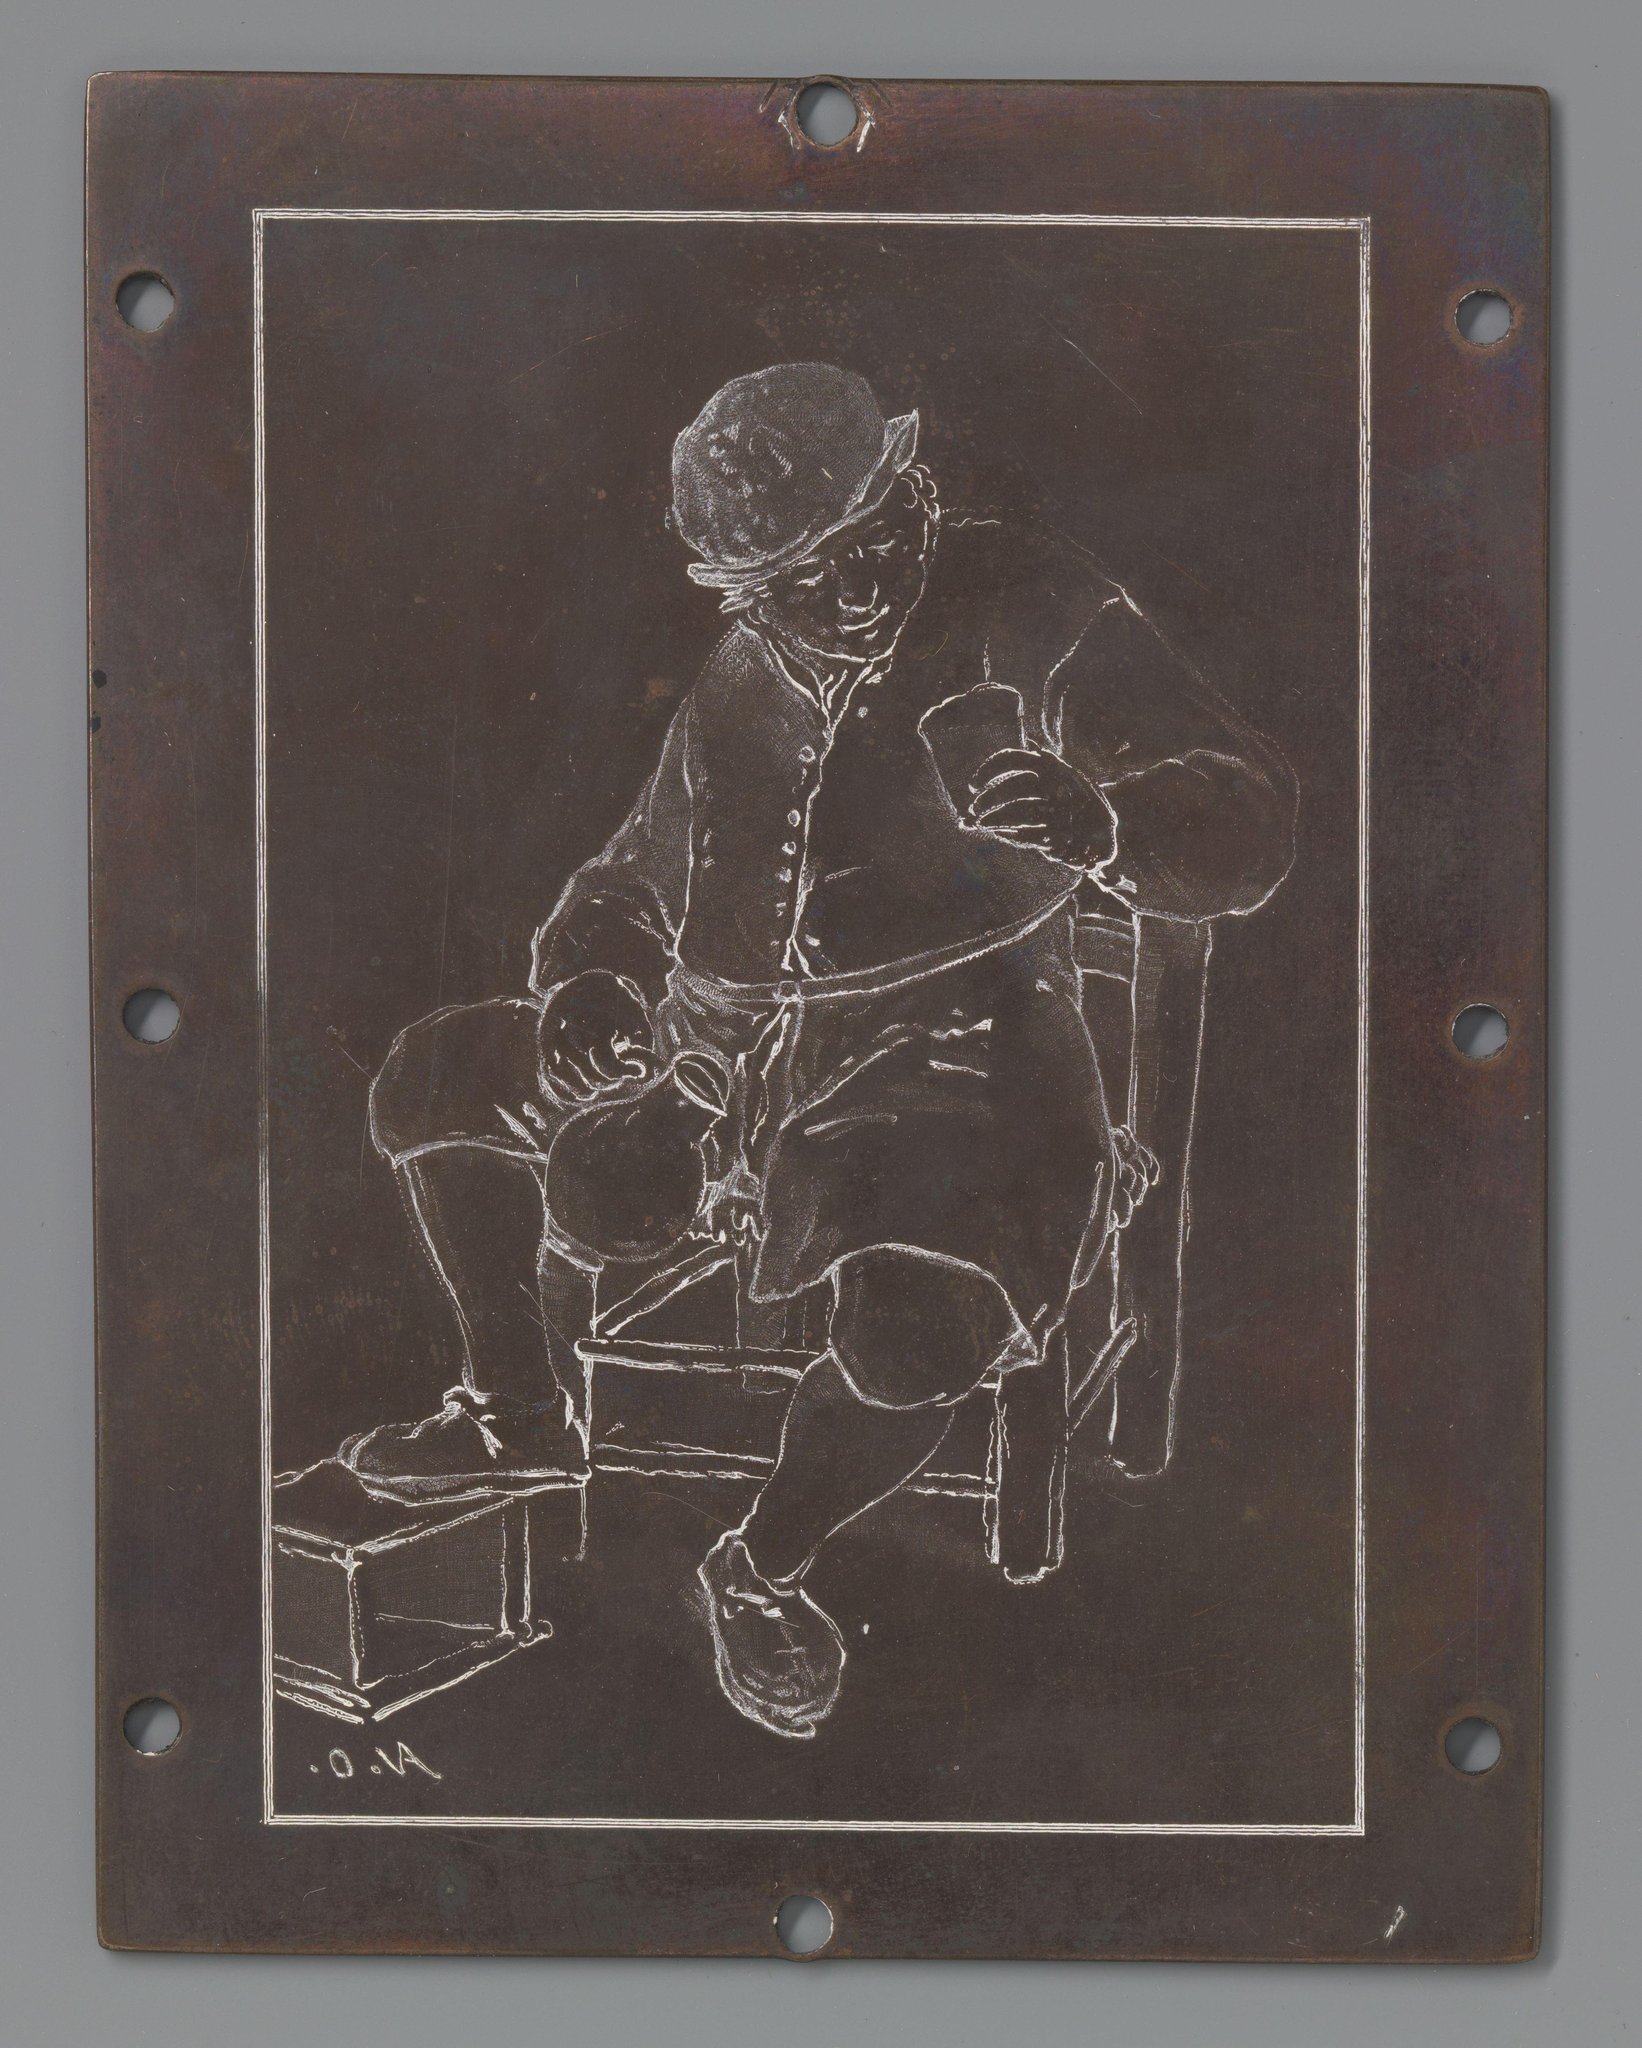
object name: copper plate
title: Zittende boer met kruik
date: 1763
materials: copper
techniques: etching, roulette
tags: sitting figure, jar, jug (used as drinking-vessel), farmers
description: Voor de prenttekening 'Zittende boer met kruik' maakte Ploos van Amstel vier verschillende platen (A, B, C, en D). Dit is plaat D. Er bestaan afdrukken van één, twee, drie of alle vier de platen in alle mogelijke combinaties. Voor afdrukken van alleen deze plaat, zie RP-P-1893-A-17945, RP-P-1893-A-17963, RP-P-1893-A-17958 en RP-P-1939-1184.